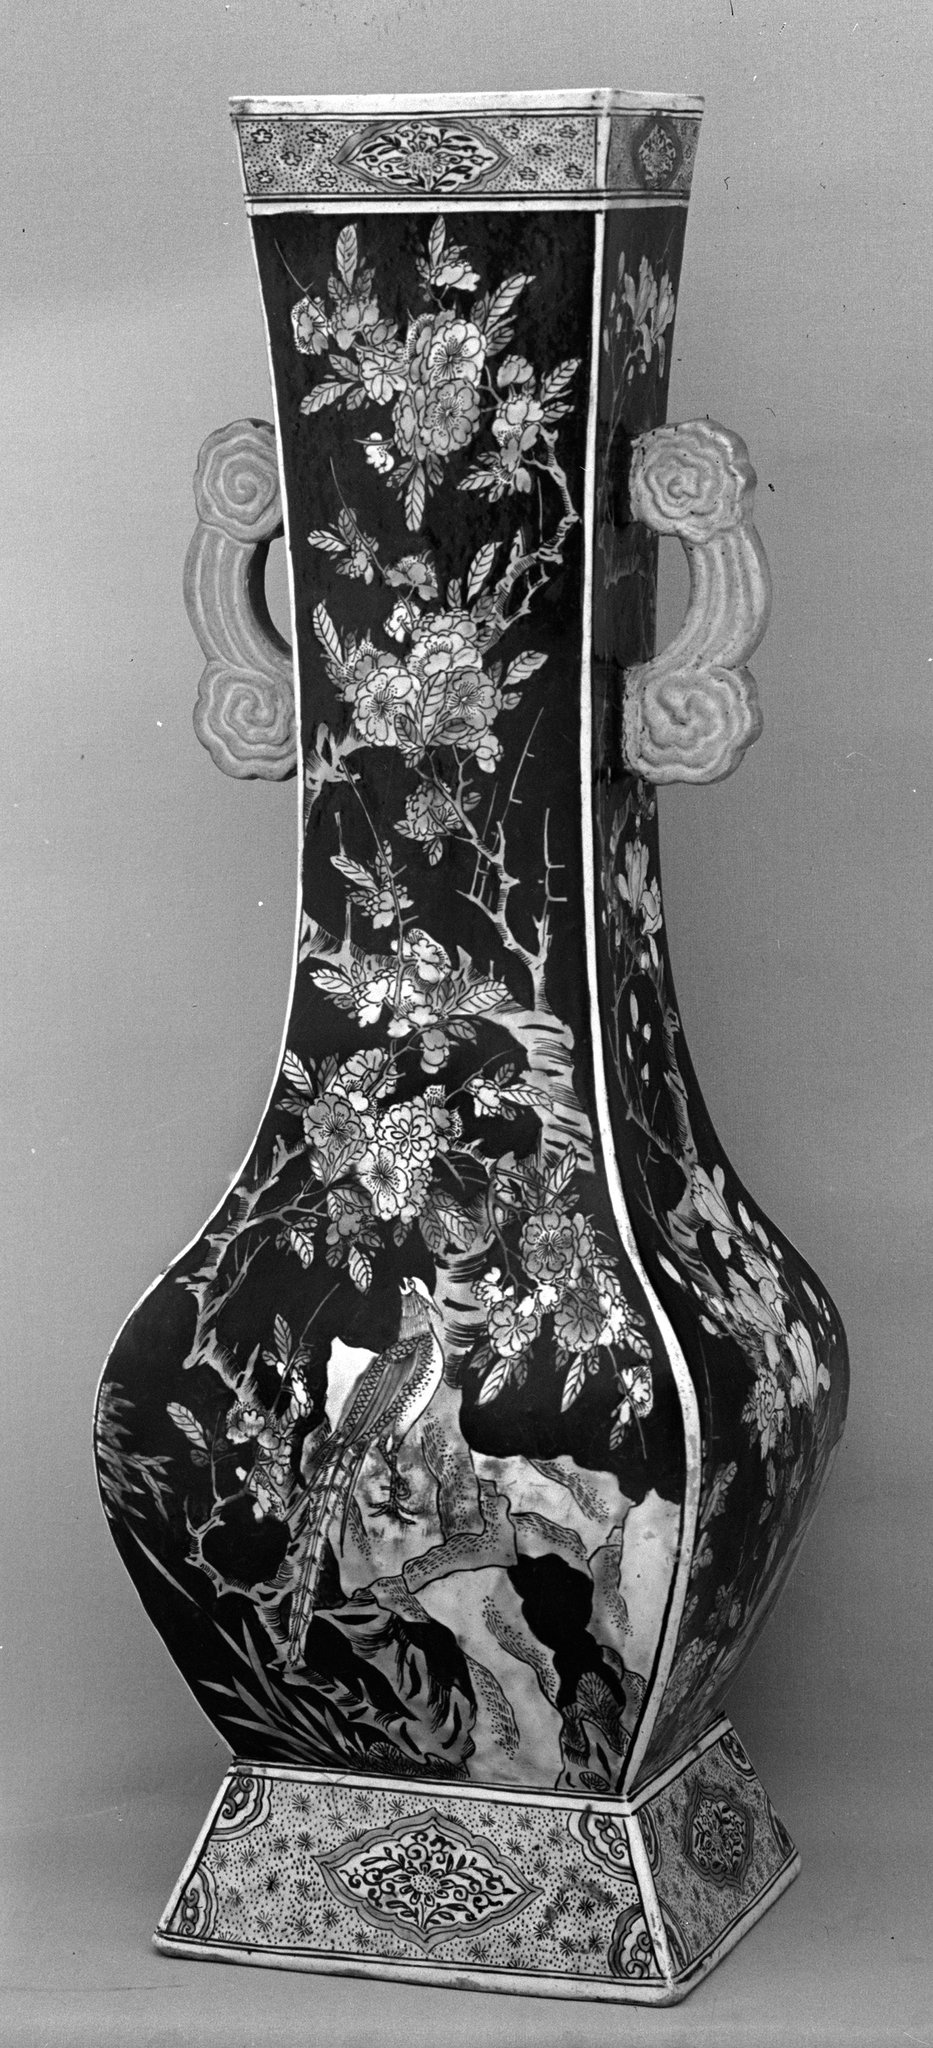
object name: vase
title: Vase with birds and flowers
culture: chinese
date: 1801-1900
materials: enamel, porcelain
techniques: painting, polychrome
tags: birds,flowers